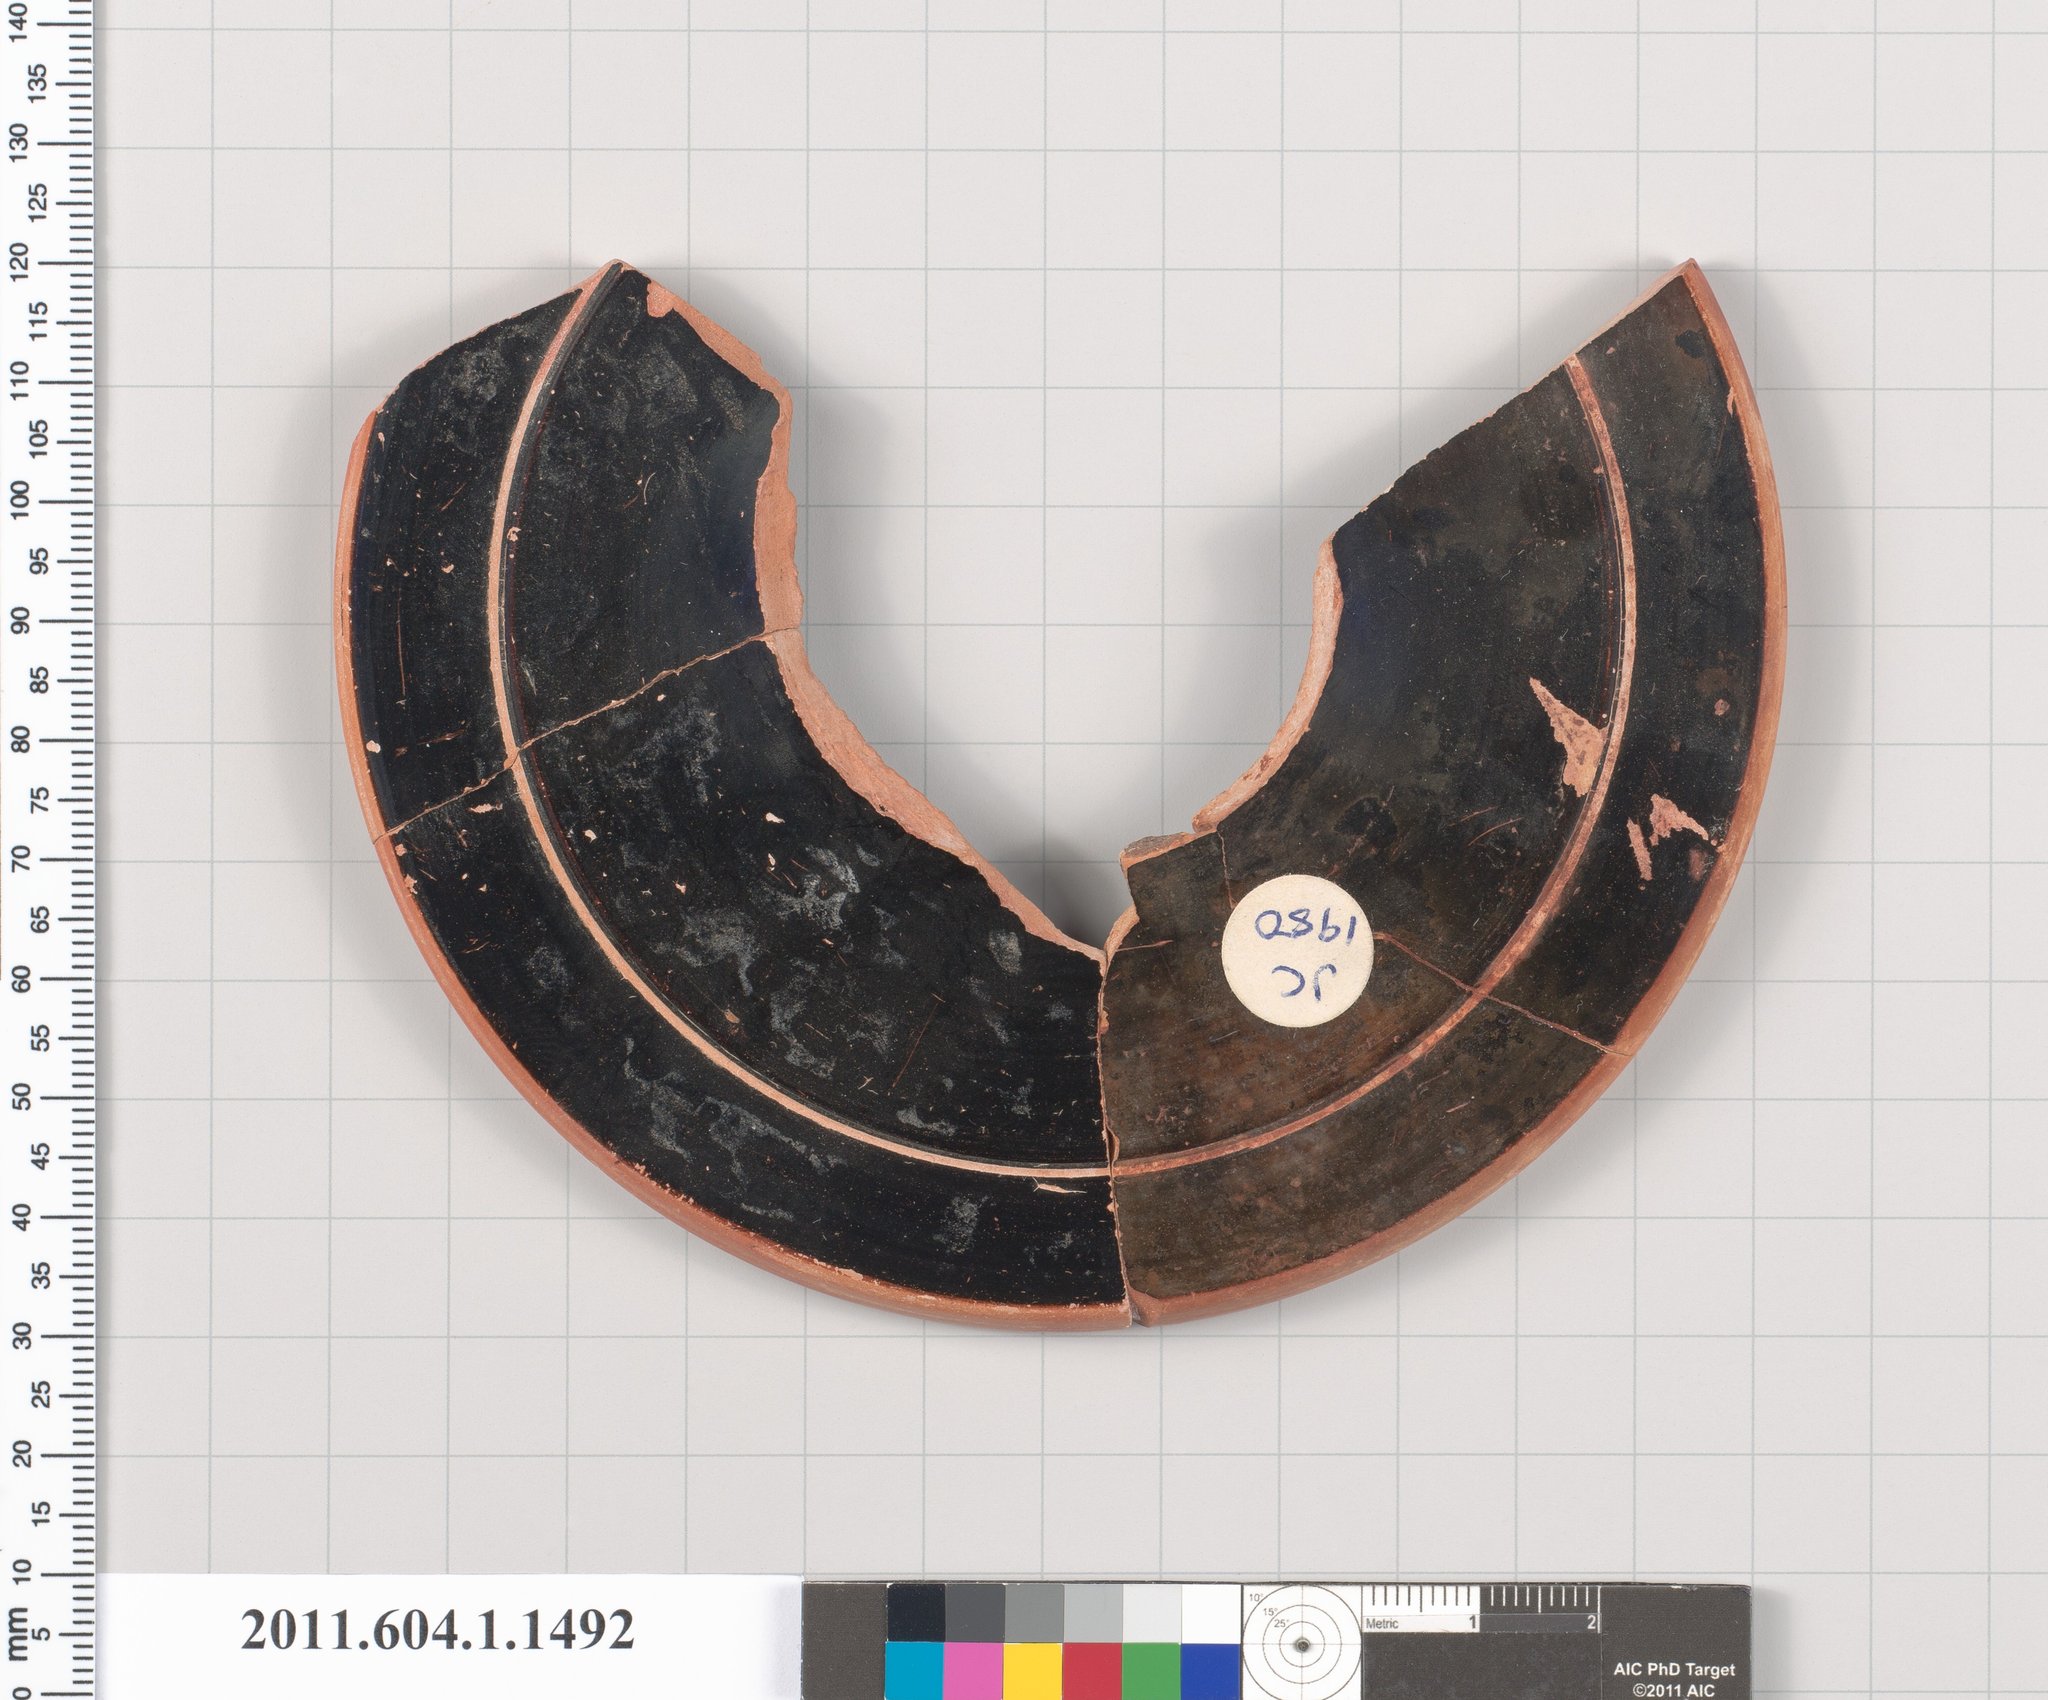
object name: kylix fragment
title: Terracotta fragment of a kylix (drinking cup)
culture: greek, attic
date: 500-401 BCE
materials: terracotta